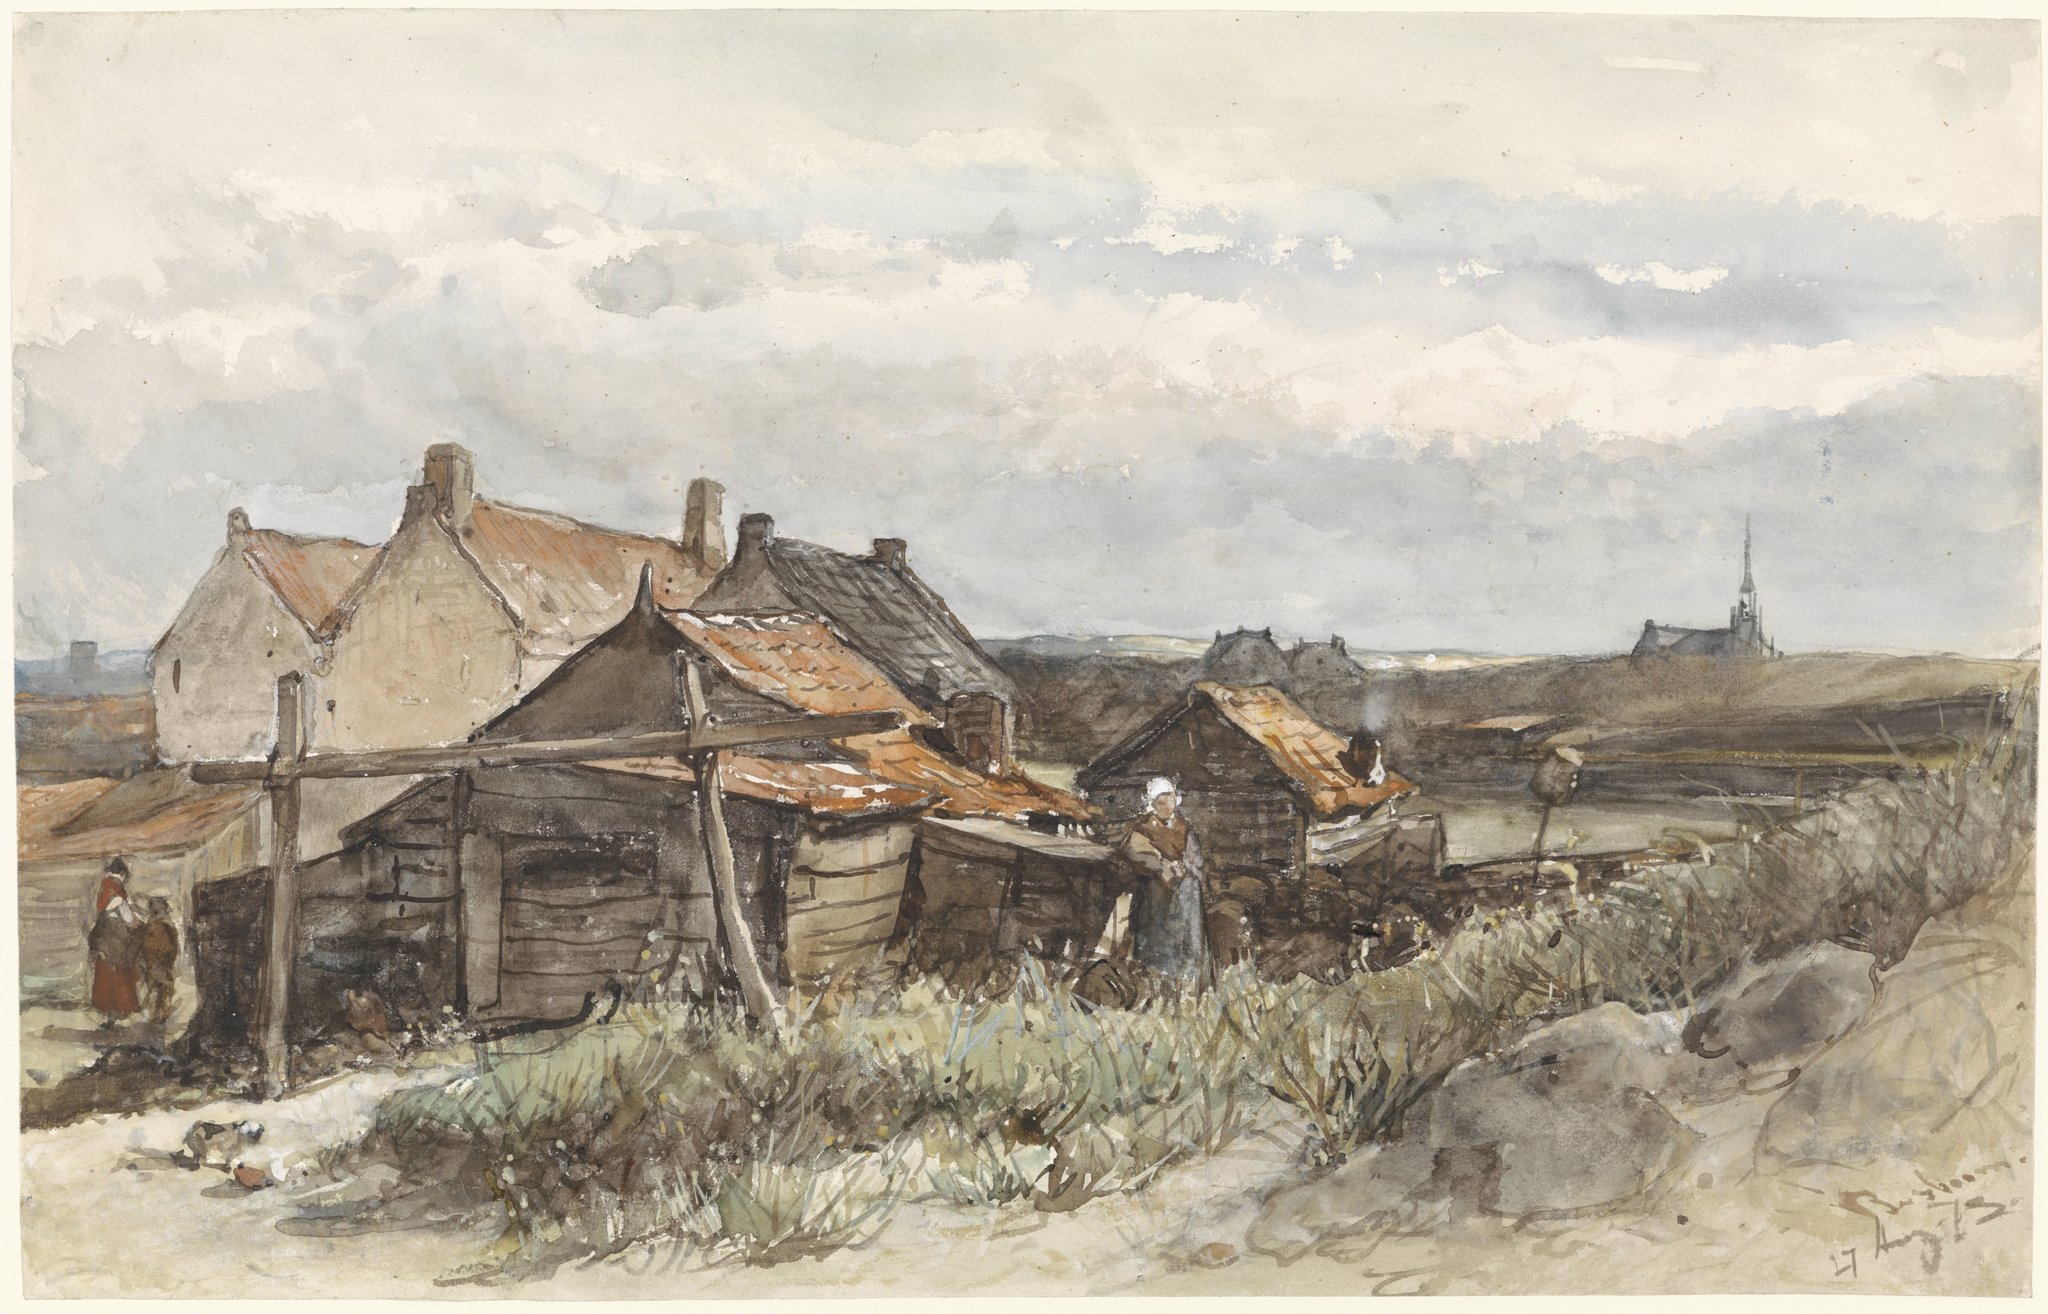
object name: watercolor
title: Fishing Family Houses in Scheveningen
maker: johannes bosboom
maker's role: draughtsman, painter, print maker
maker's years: 1817-1891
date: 1873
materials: paint, paper, pencil, watercolor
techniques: brush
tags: dunes (sea not visible); in the dunes, rural housing, e.g. country-house, villa, cottage, fisherman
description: For the last two weeks of August in 1873, Johannes Bosboom and his wife stayed at Zeerust Hotel in Scheveningen. There he drew several sketches, over fifteen of which he turned into watercolours. At the heart of this watercolour are a few simple, timberbuilt fishermen’s houses. In the distance, behind the dune, overgrown with beach grass, stands the Dutch Reformed church of Scheveningen.